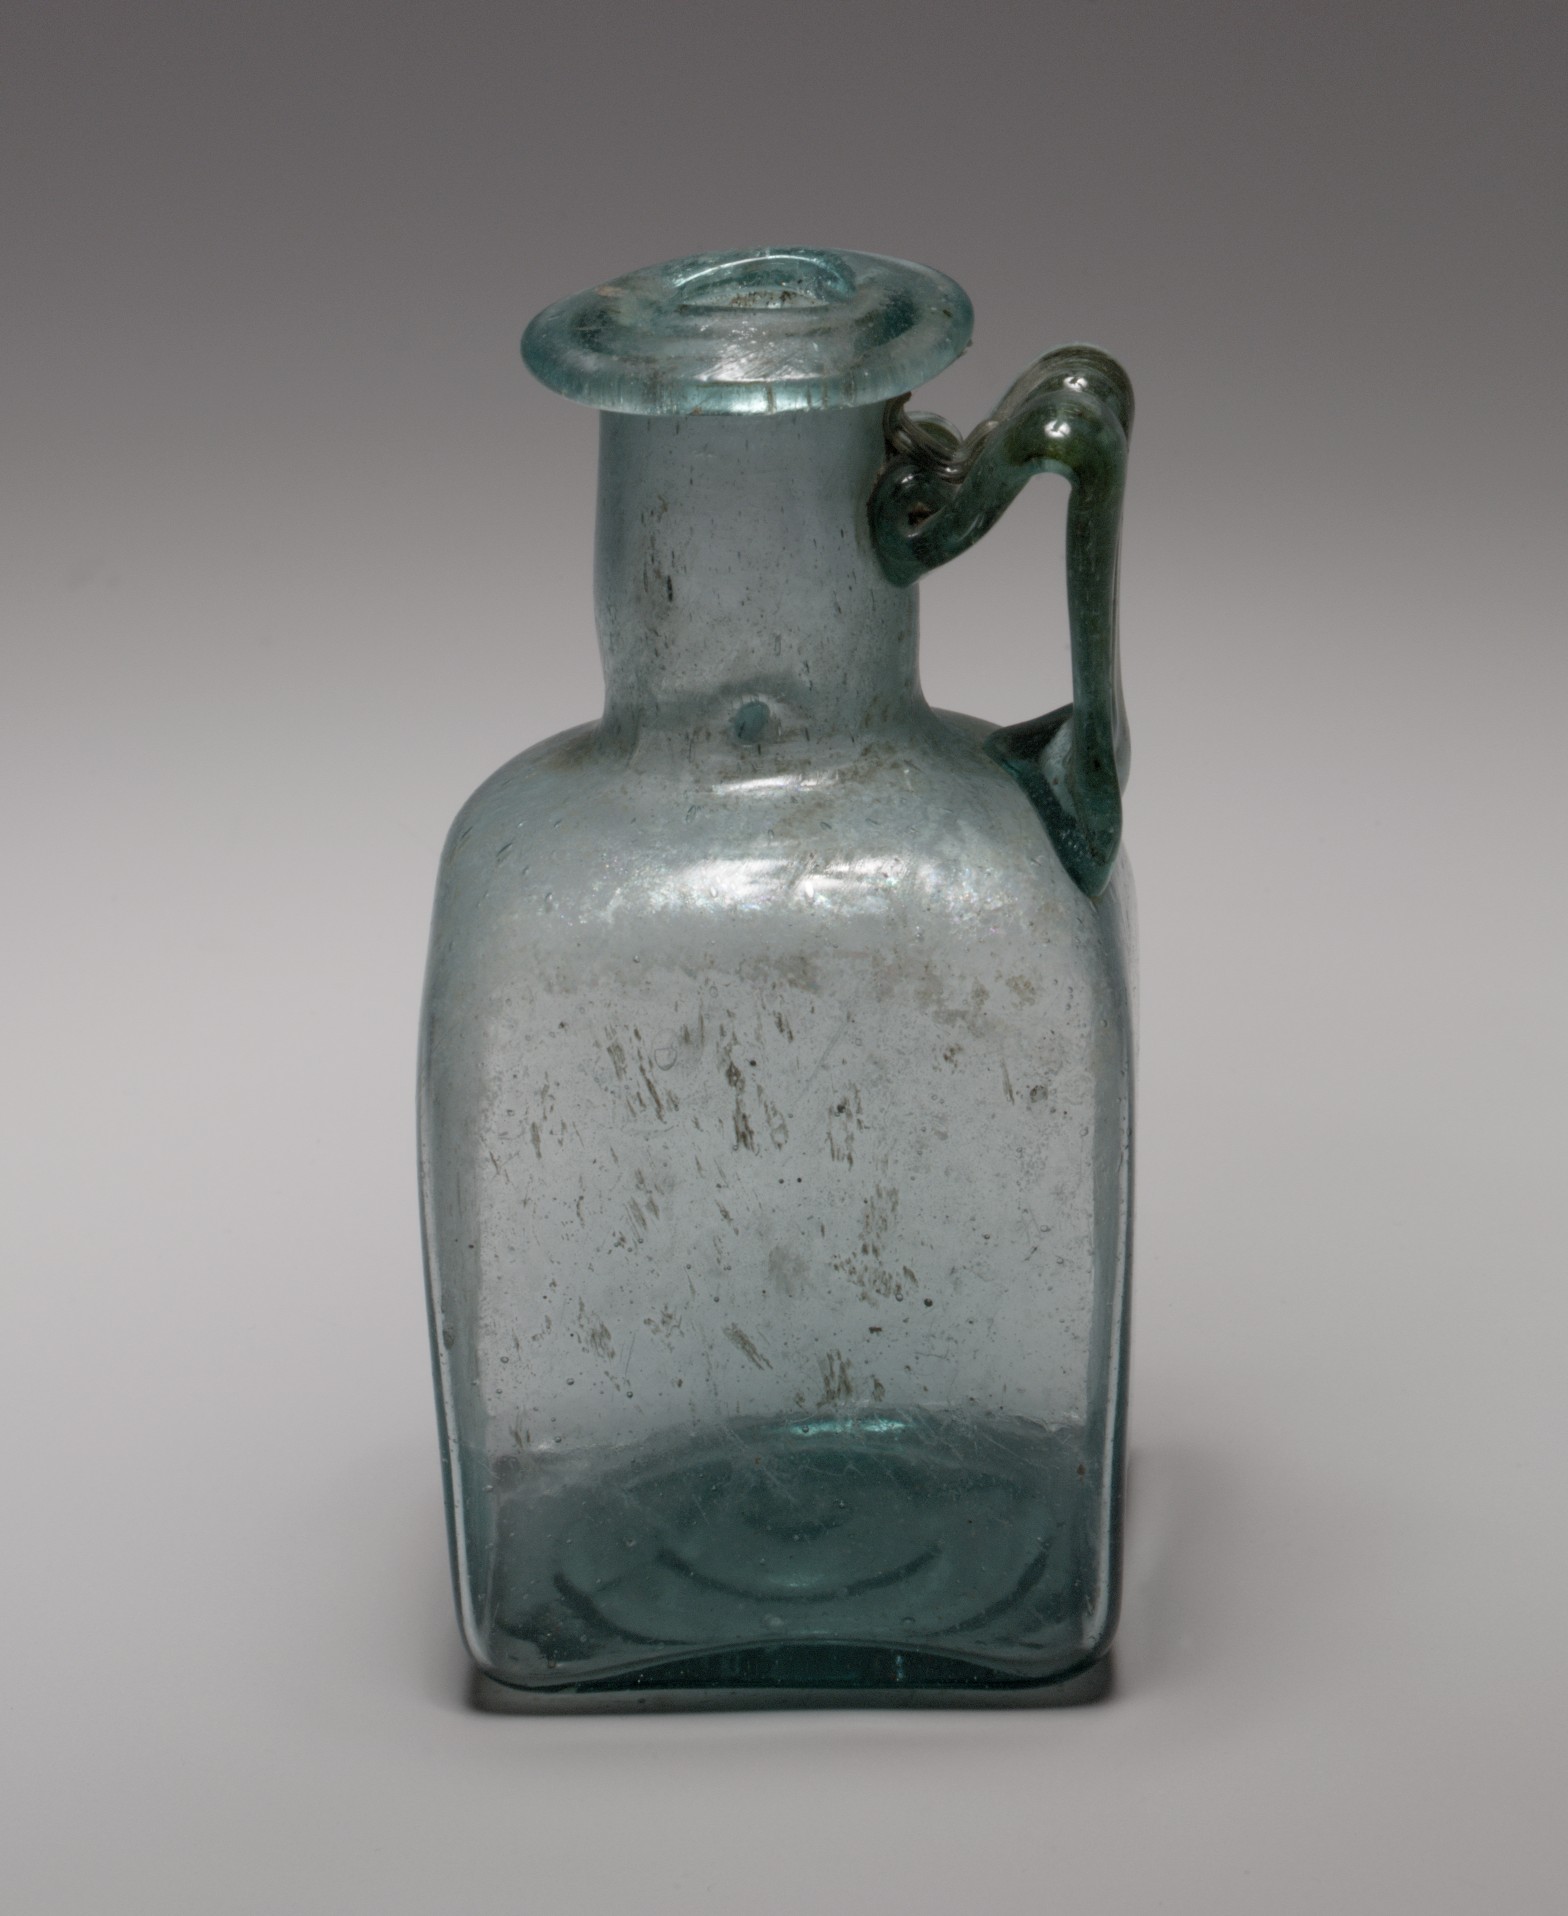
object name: bottle, square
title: Glass square bottle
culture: roman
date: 1-300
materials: glass